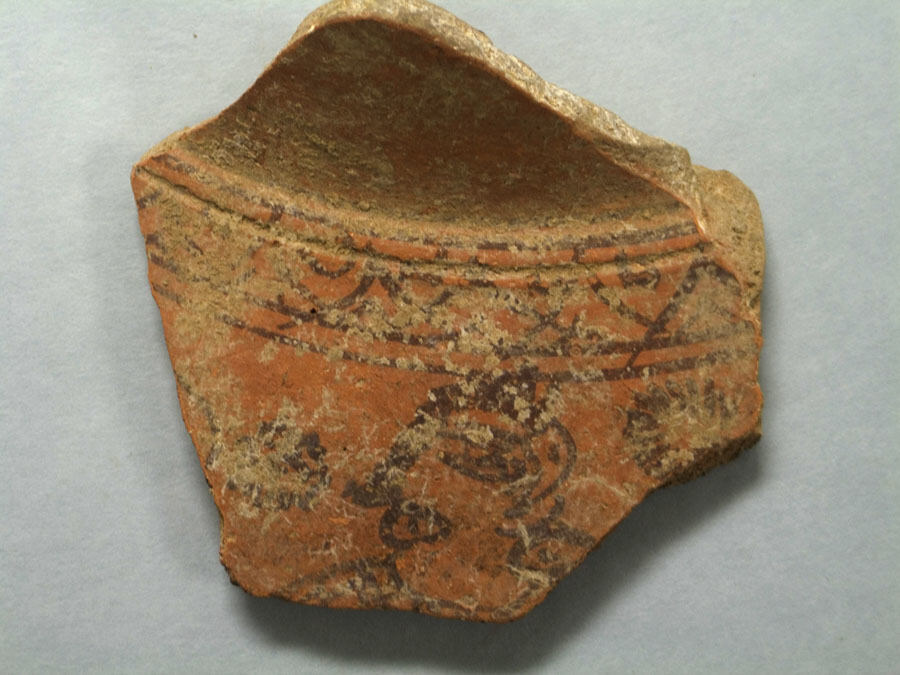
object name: shard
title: Shard: Encrusted Neckpiece with Head and Hand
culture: pakistani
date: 301-500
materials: terracotta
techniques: painting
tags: gandhara